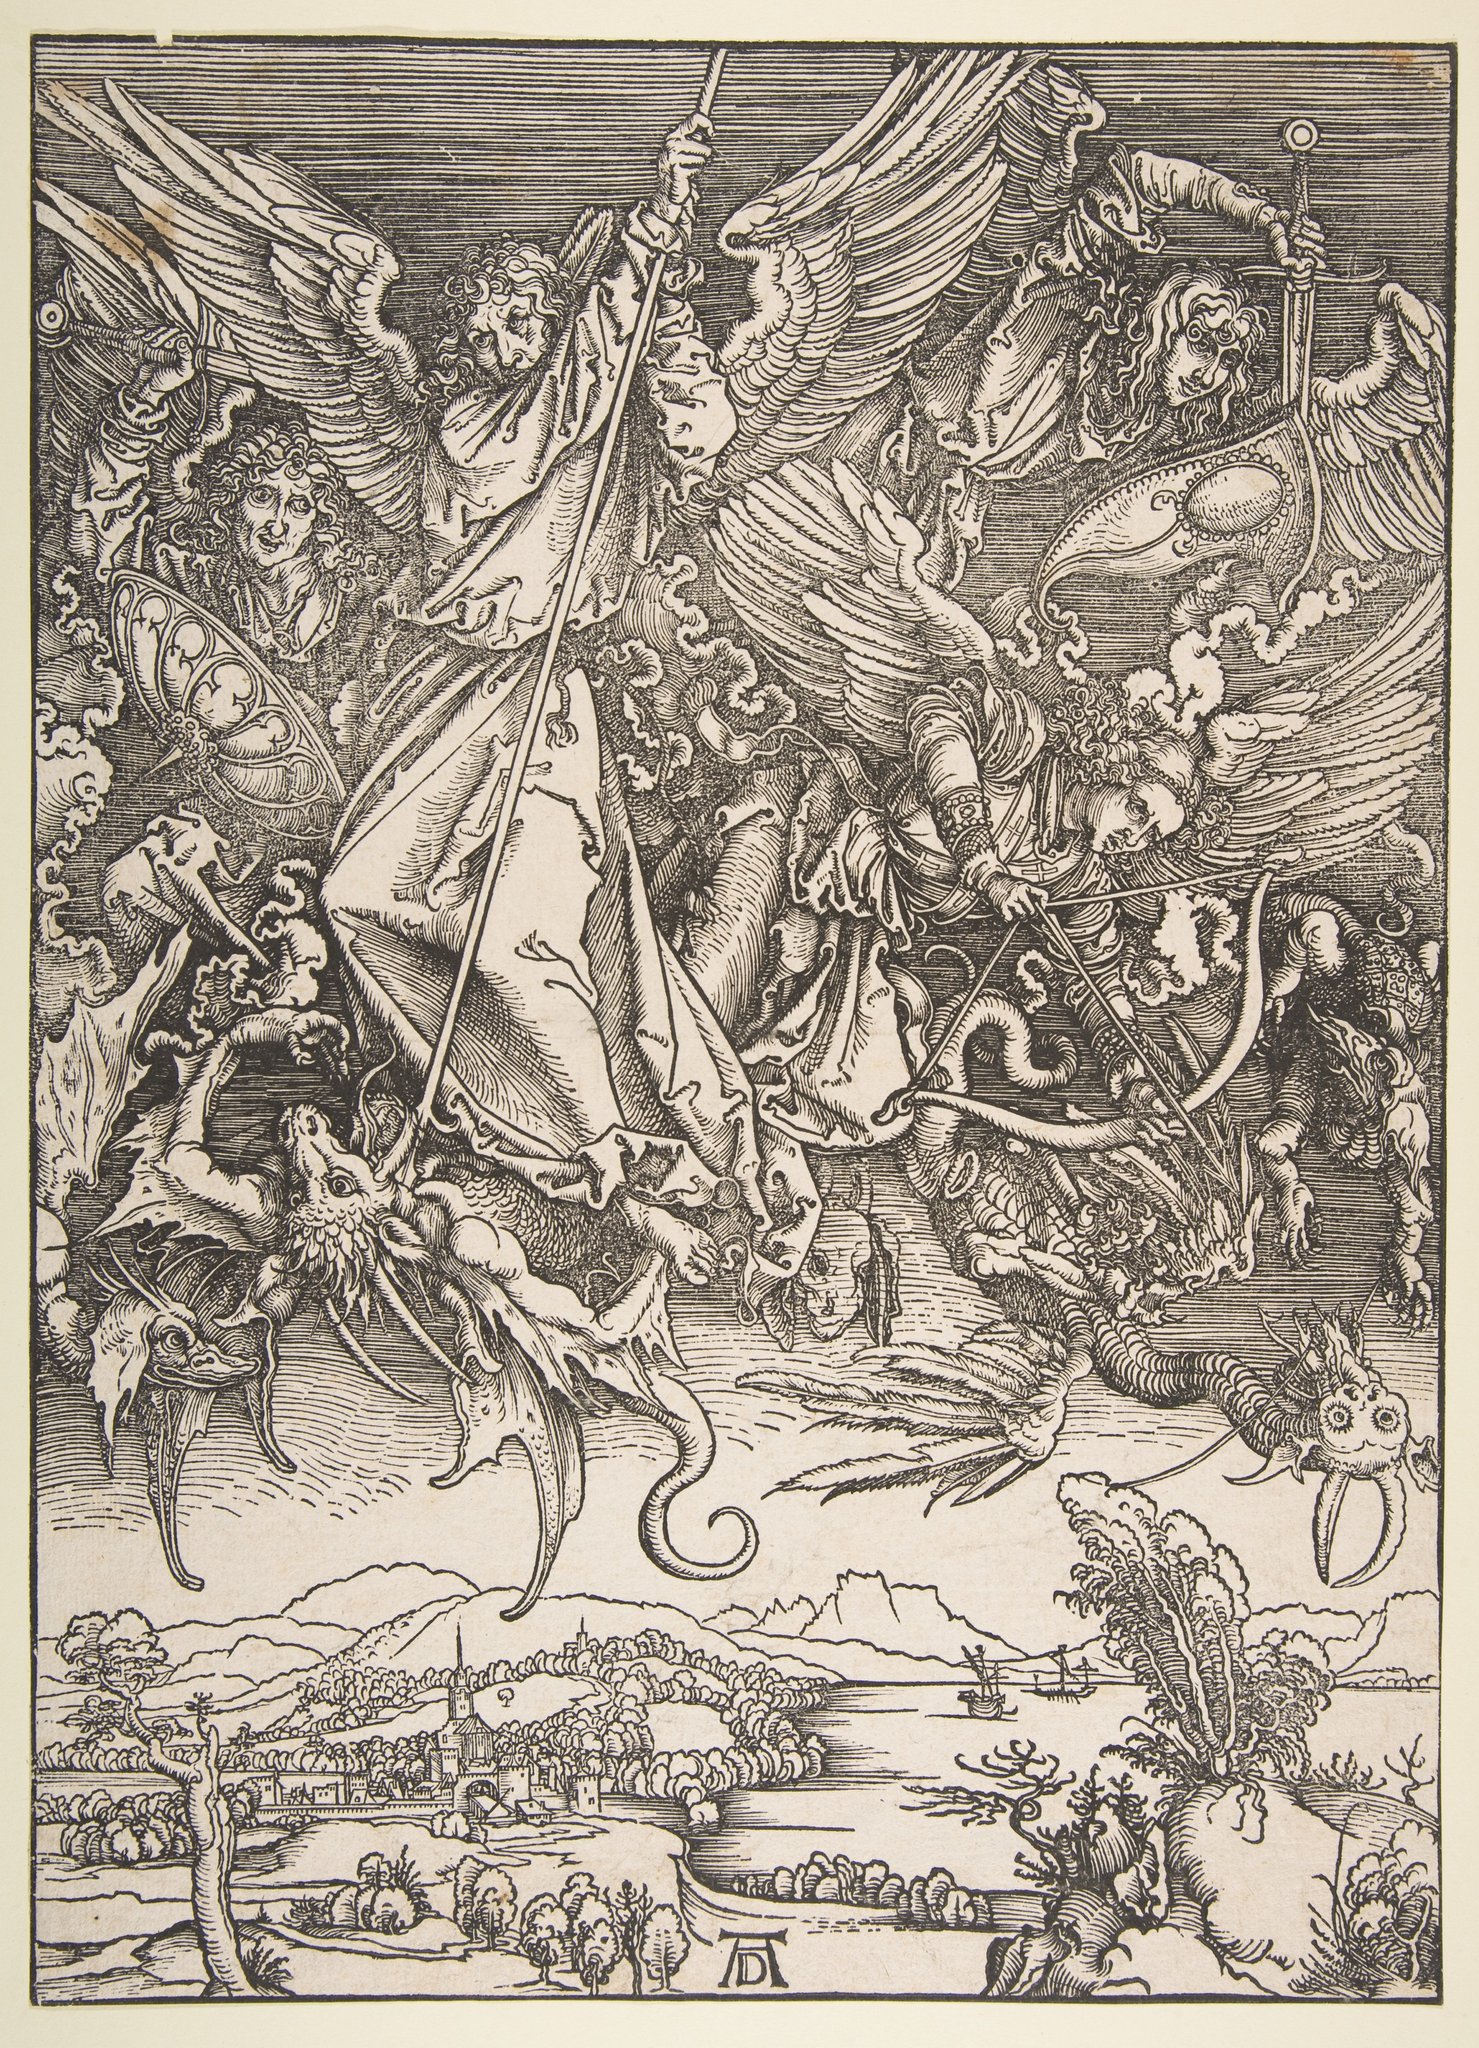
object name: print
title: Saint Michael Fighting the Dragon, from "The Apocalypse"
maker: albrecht dürer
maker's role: artist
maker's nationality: german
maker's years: 1471-1528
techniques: woodcut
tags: dragons,saint michael